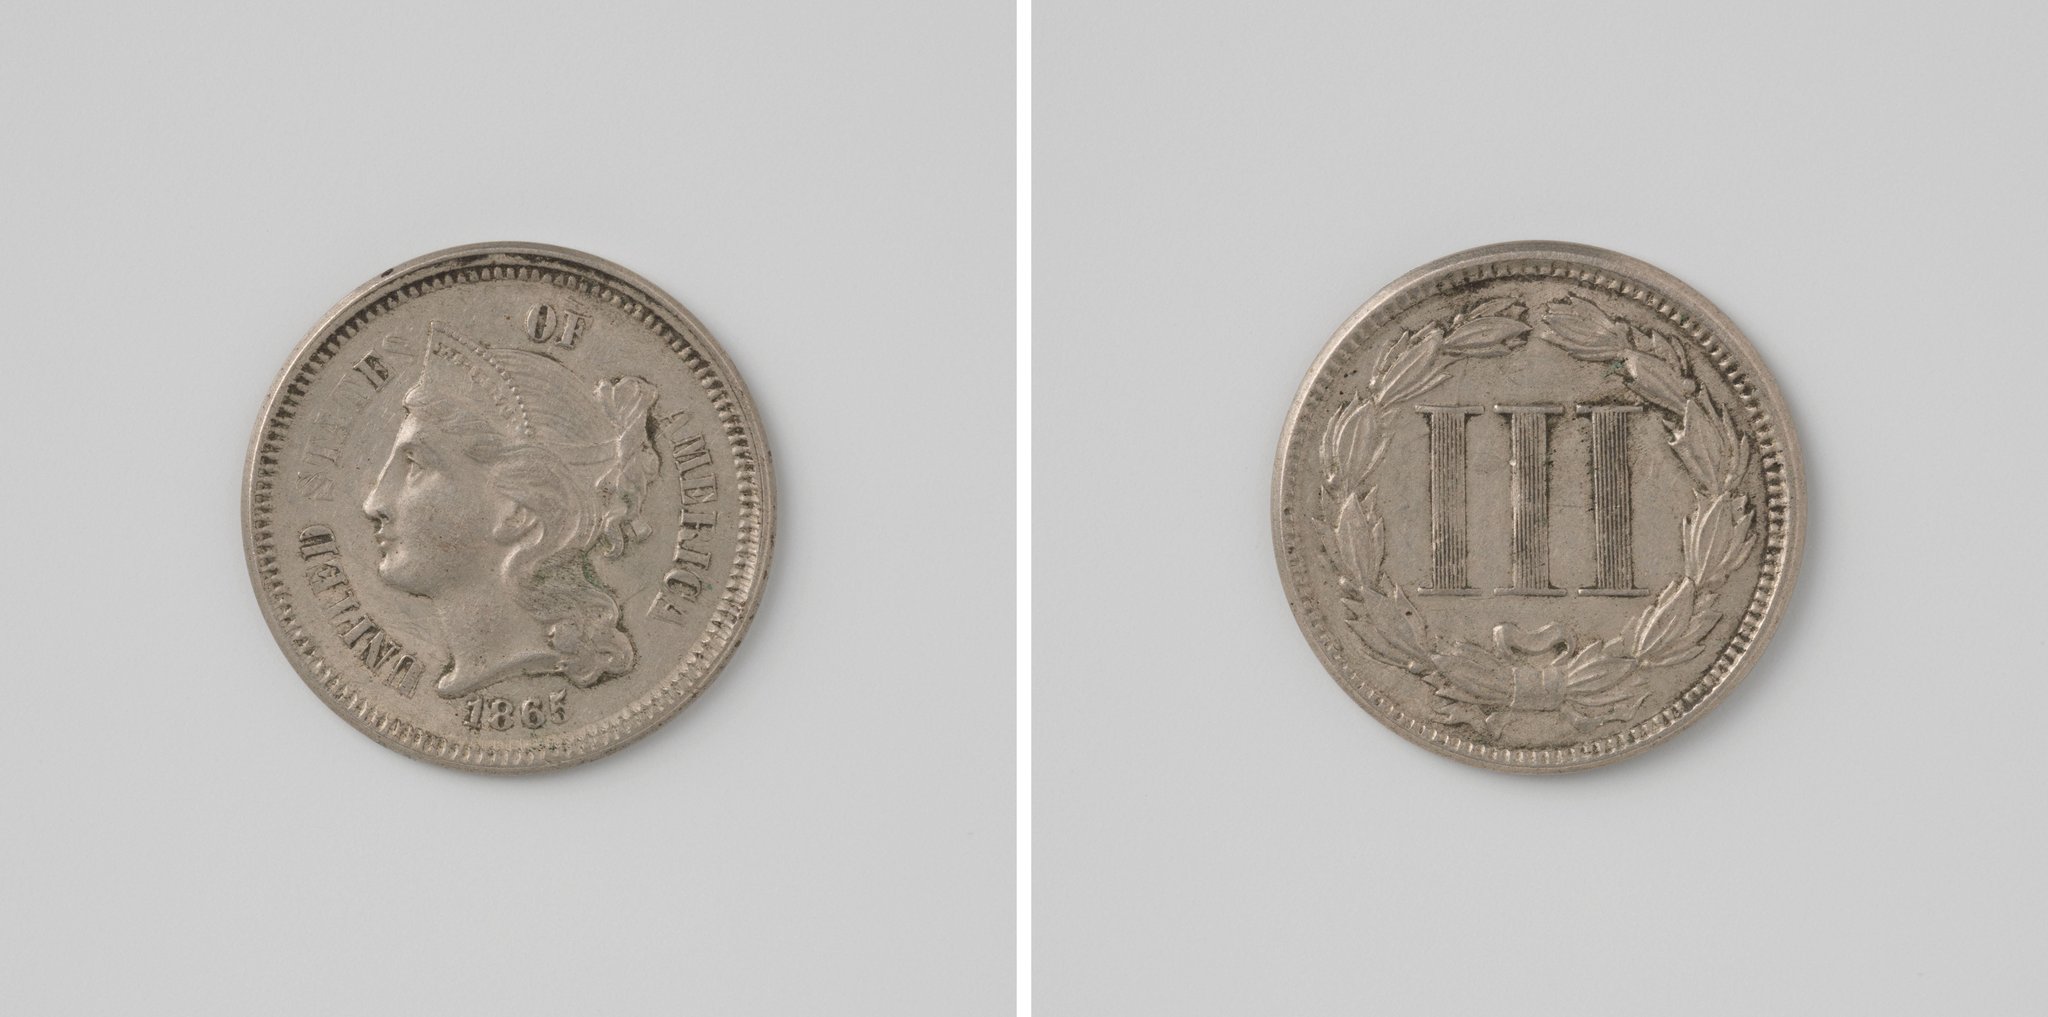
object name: coin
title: Verenigde Staten van Amerika, 3 cents, 1865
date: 1865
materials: nickel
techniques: striking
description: Koper-nikkelen munt. Voorzijde: hoofd (coronet head) naar links, waaronder jaartal. Keerzijde: tussen twee samengebonden takken waarde-aanduiding: III. Gladde rand.